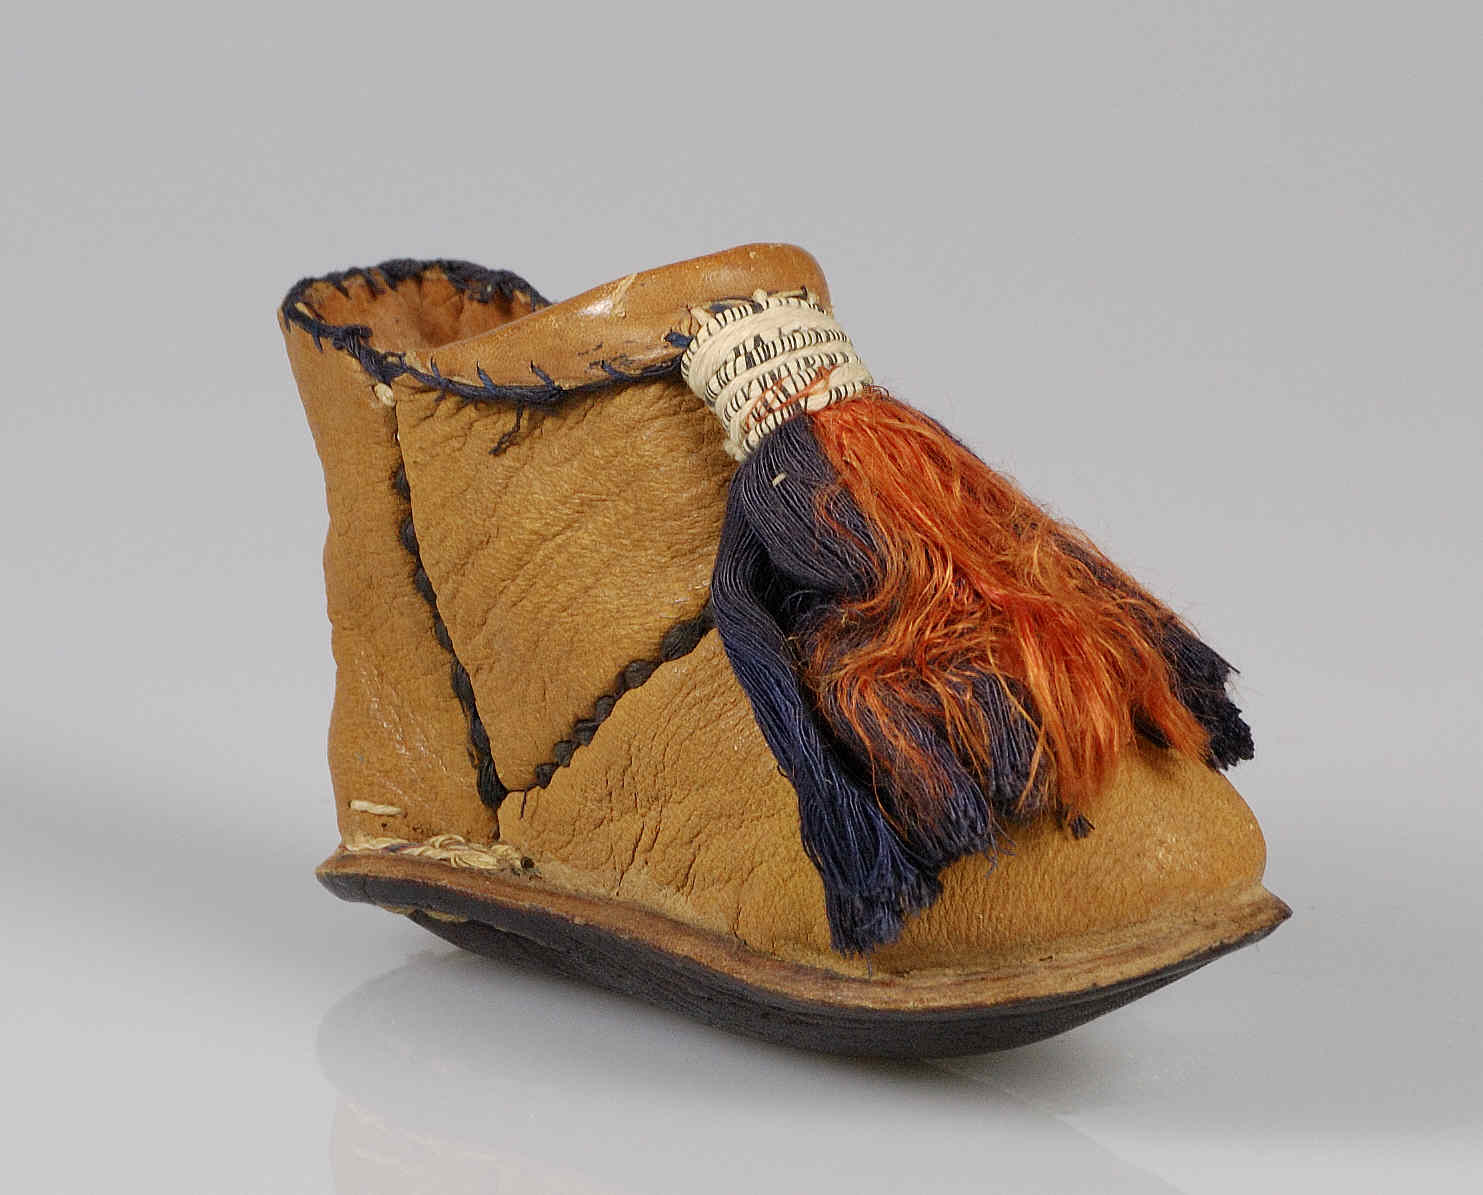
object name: boot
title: Children's Ankle Boots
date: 1867-1933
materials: cotton, leather, silk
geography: syria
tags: boots